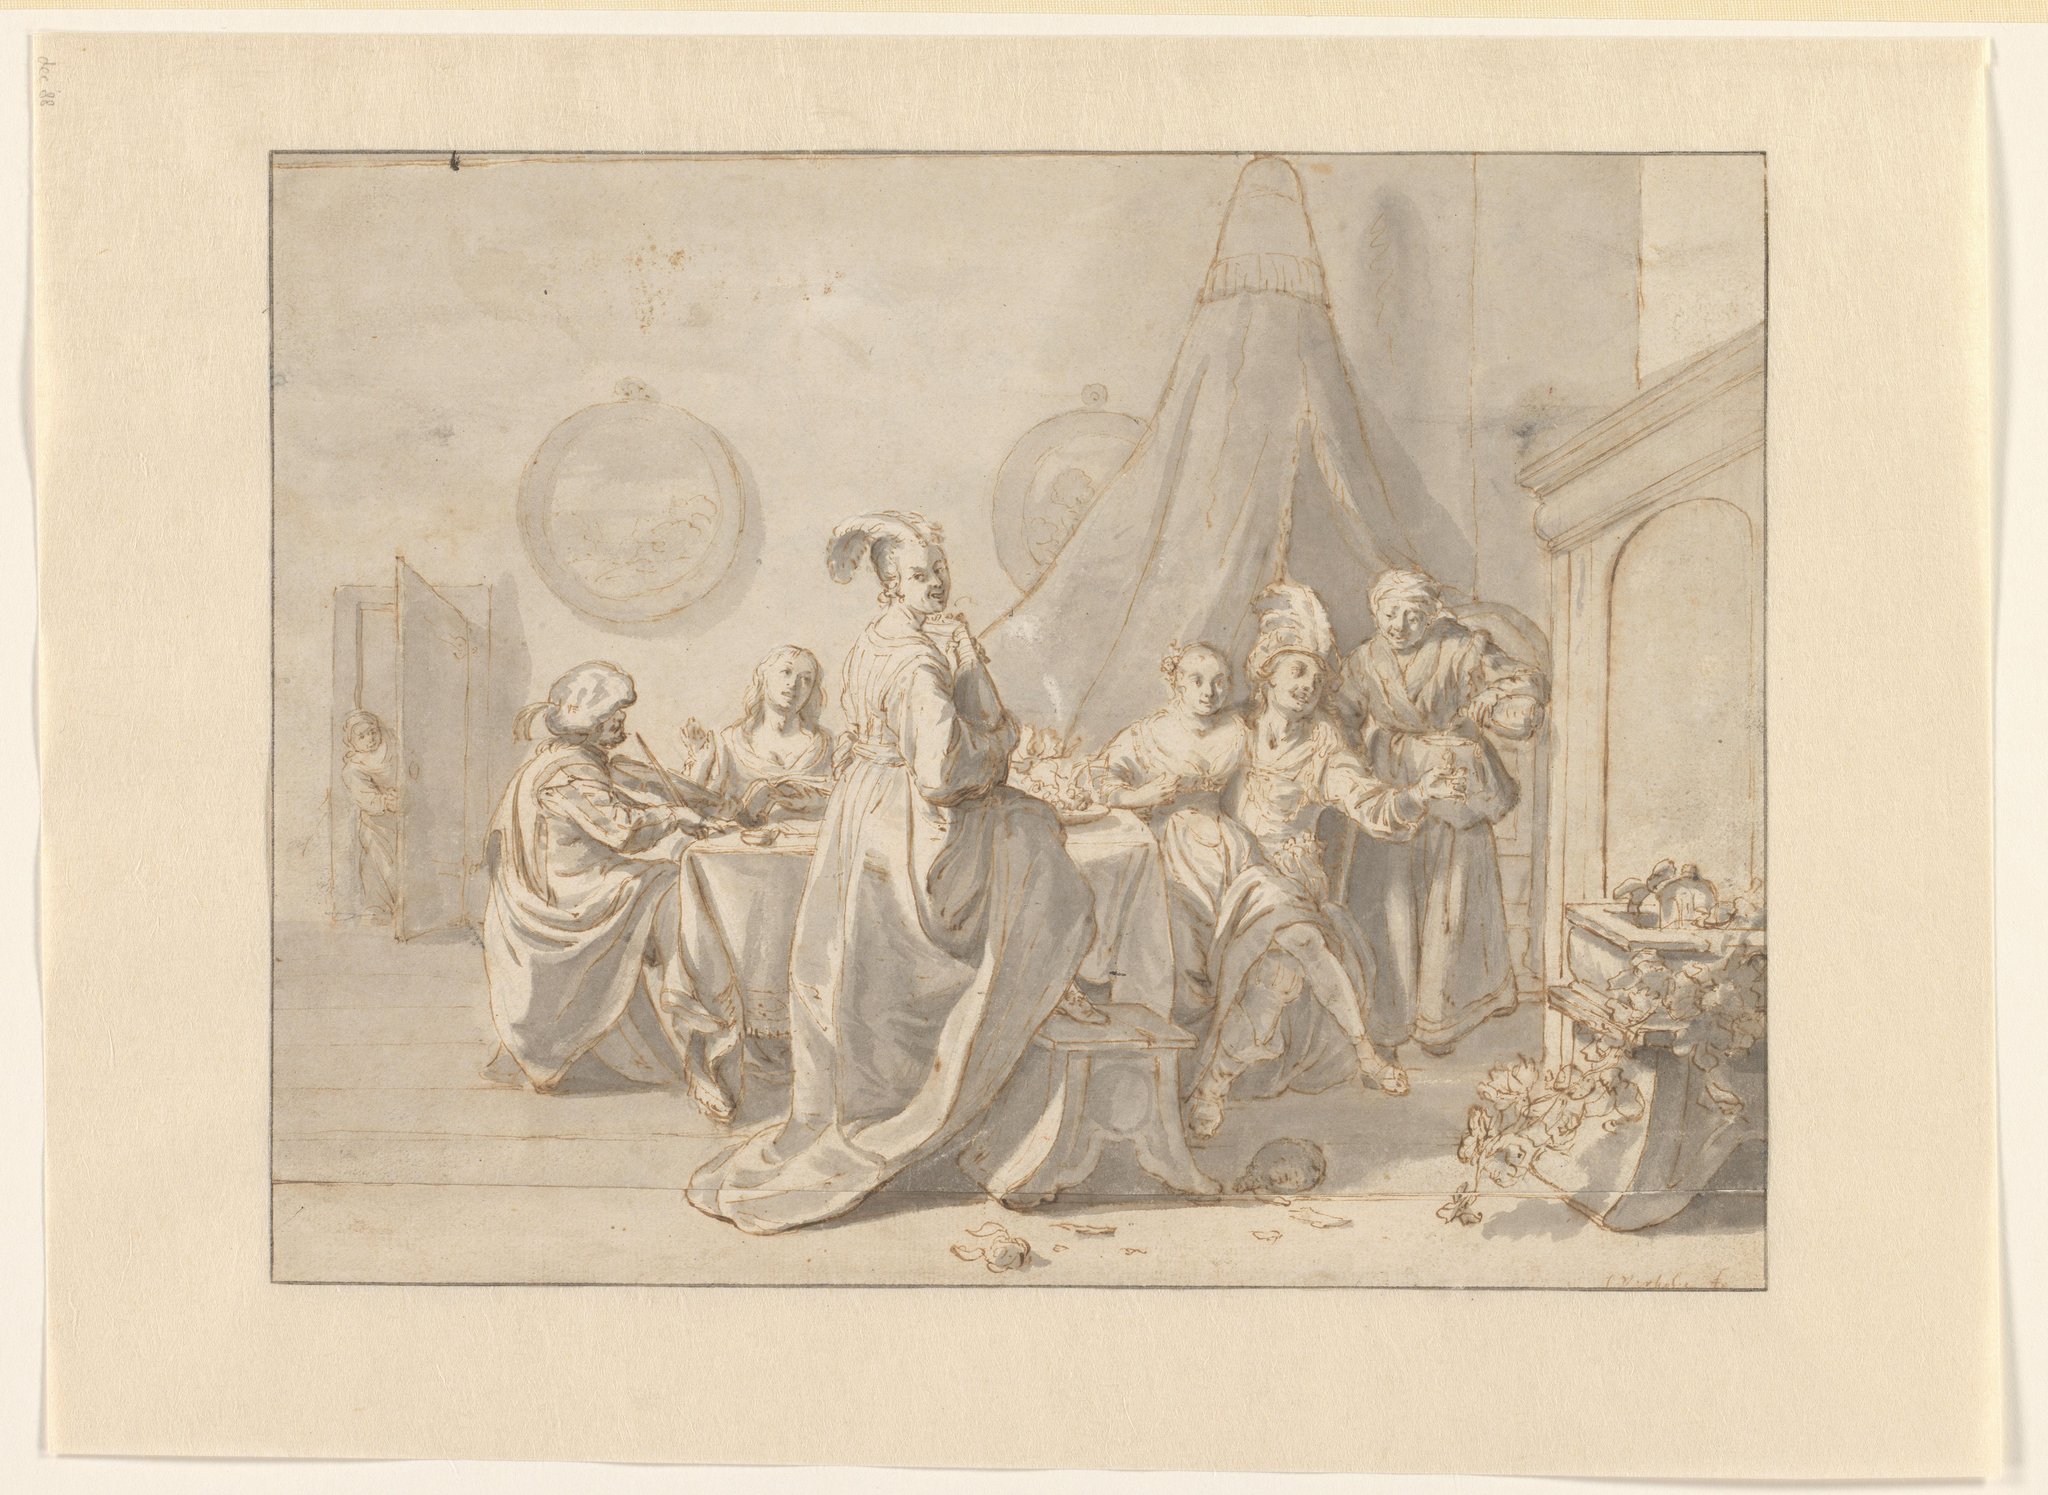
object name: drawing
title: De verloren zoon in het bordeel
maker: jan verkolje (i)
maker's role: draughtsman, painter, print maker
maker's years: 1650-1693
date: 1660-1693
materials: ink, paper, pencil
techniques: brush, pen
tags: brothel, violin, fiddle, lute, and special forms of lute, e.g.: theorbo, the prodigal son in the midst of prostitutes feasting and dissipating his patrimony, usually in a brothel or inn, more than one musician with instrument